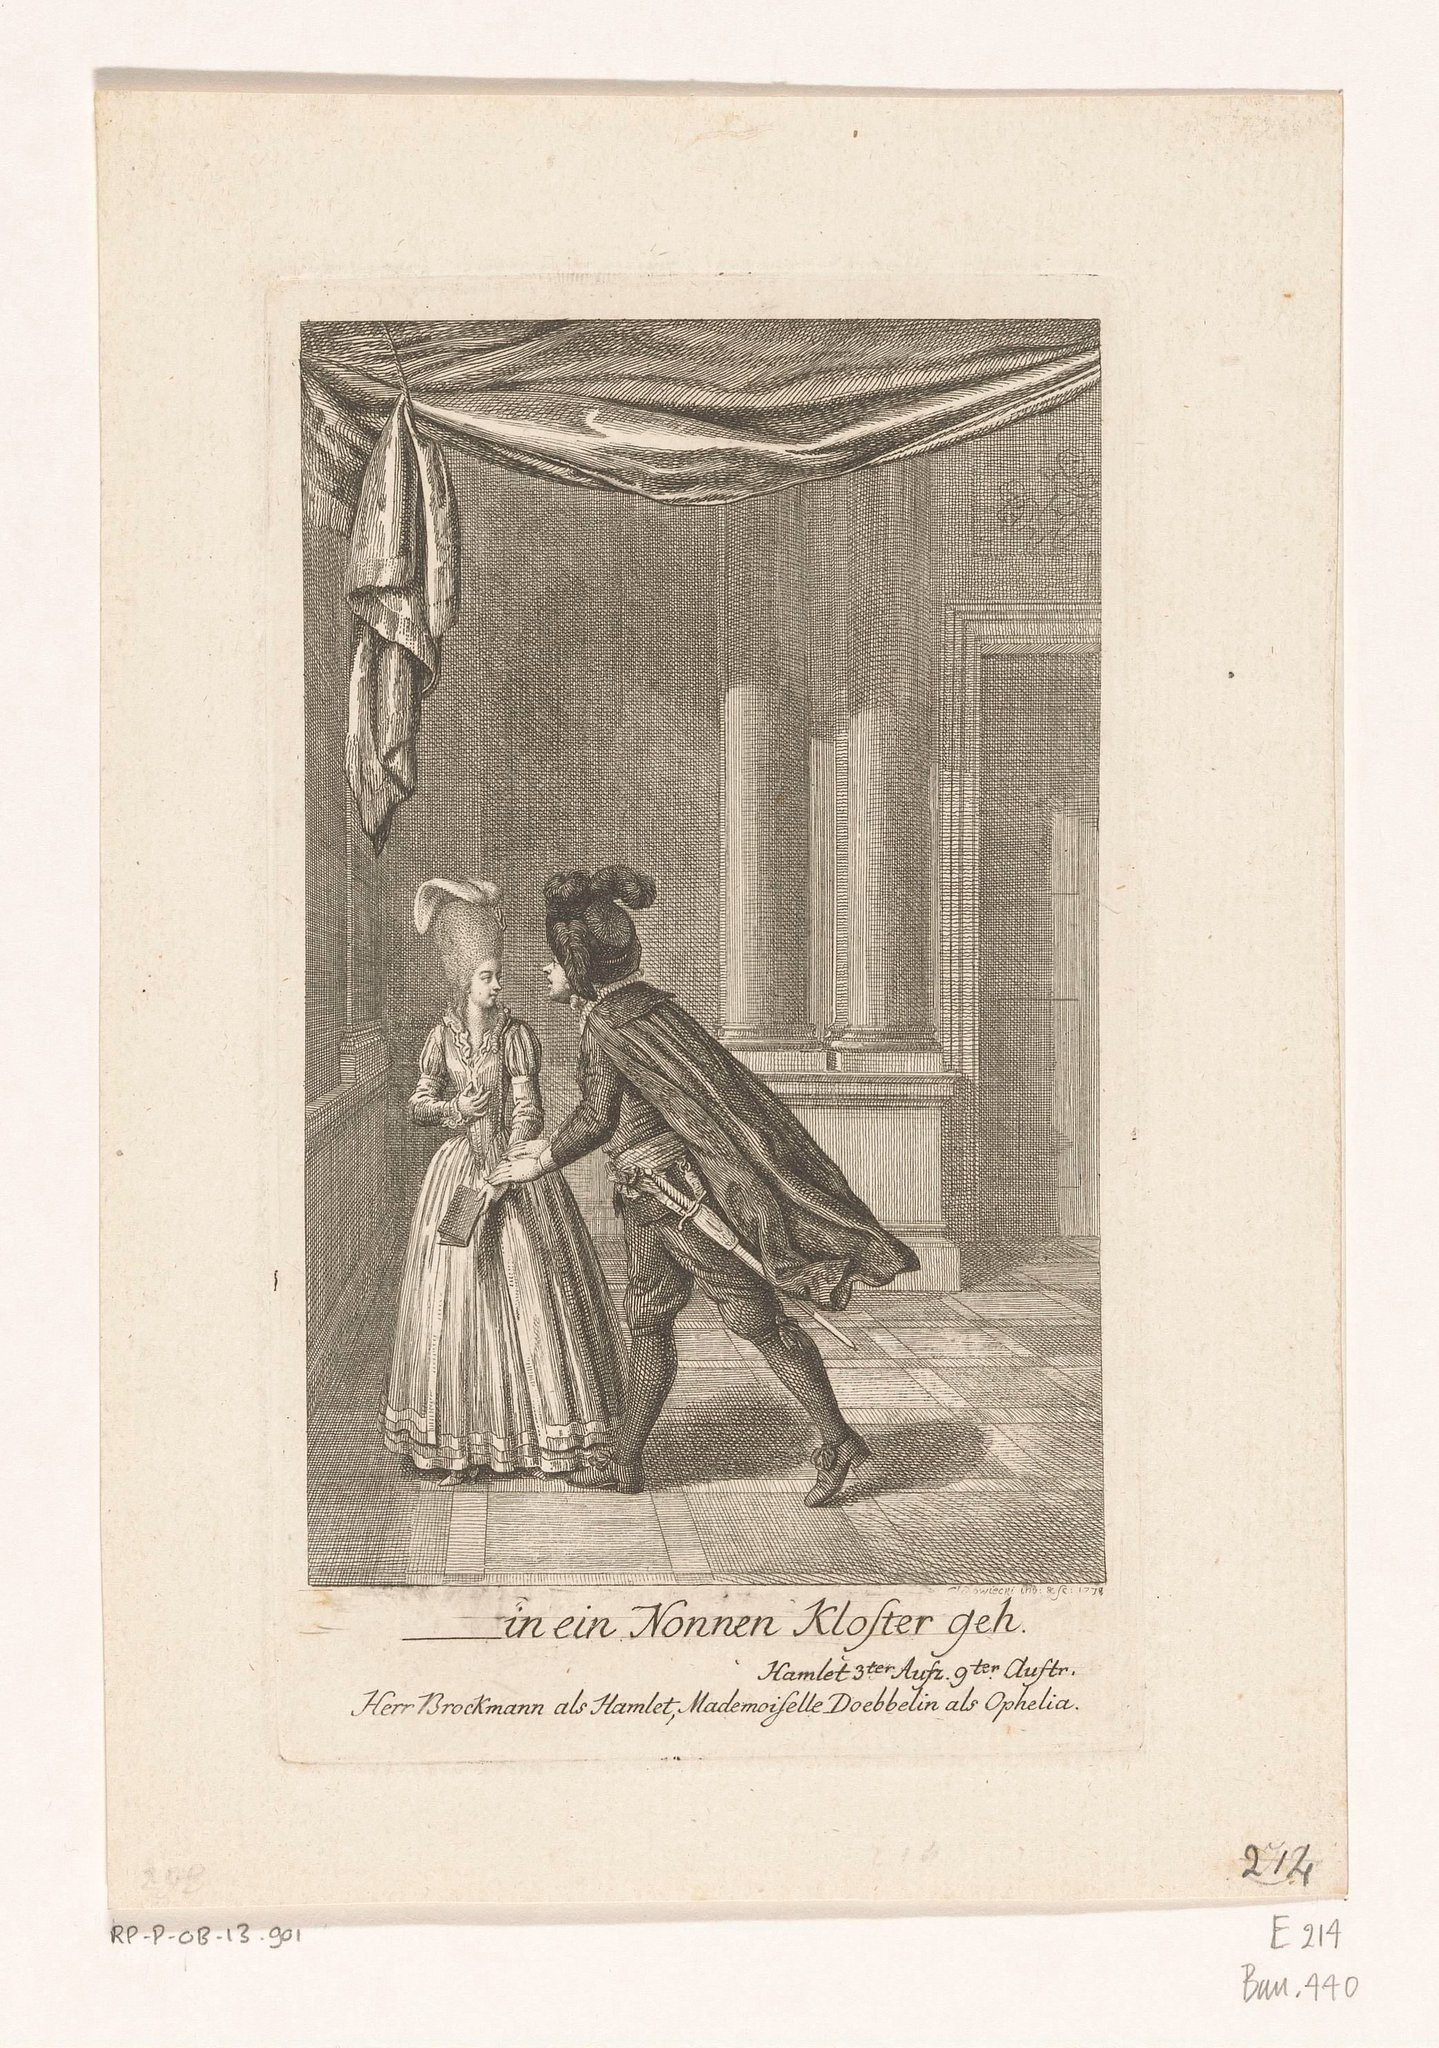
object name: print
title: Hamlet en Ophelia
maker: daniel nikolaus chodowiecki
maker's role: draughtsman, print maker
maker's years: 1726-1801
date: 1778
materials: paper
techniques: etching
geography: berlin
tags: vienna, cologne, berlin, william shakespeare, hamlet, prince of denmark, theatre, theatrical performance, book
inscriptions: collector's mark: Lugt 2228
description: Prent ook gebruikt in: Litteratur- und Theater-Zeitung. Berlijn: Arnold Wever, 1778. In december 1777 werd Hamlet voor het eerst in Berlijn uitgevoerd met Johann Franz Hieronymus Brockmann in de hoofdrol. Chodowiecki bezocht verschillende uitvoeringen van dit toneelstuk.